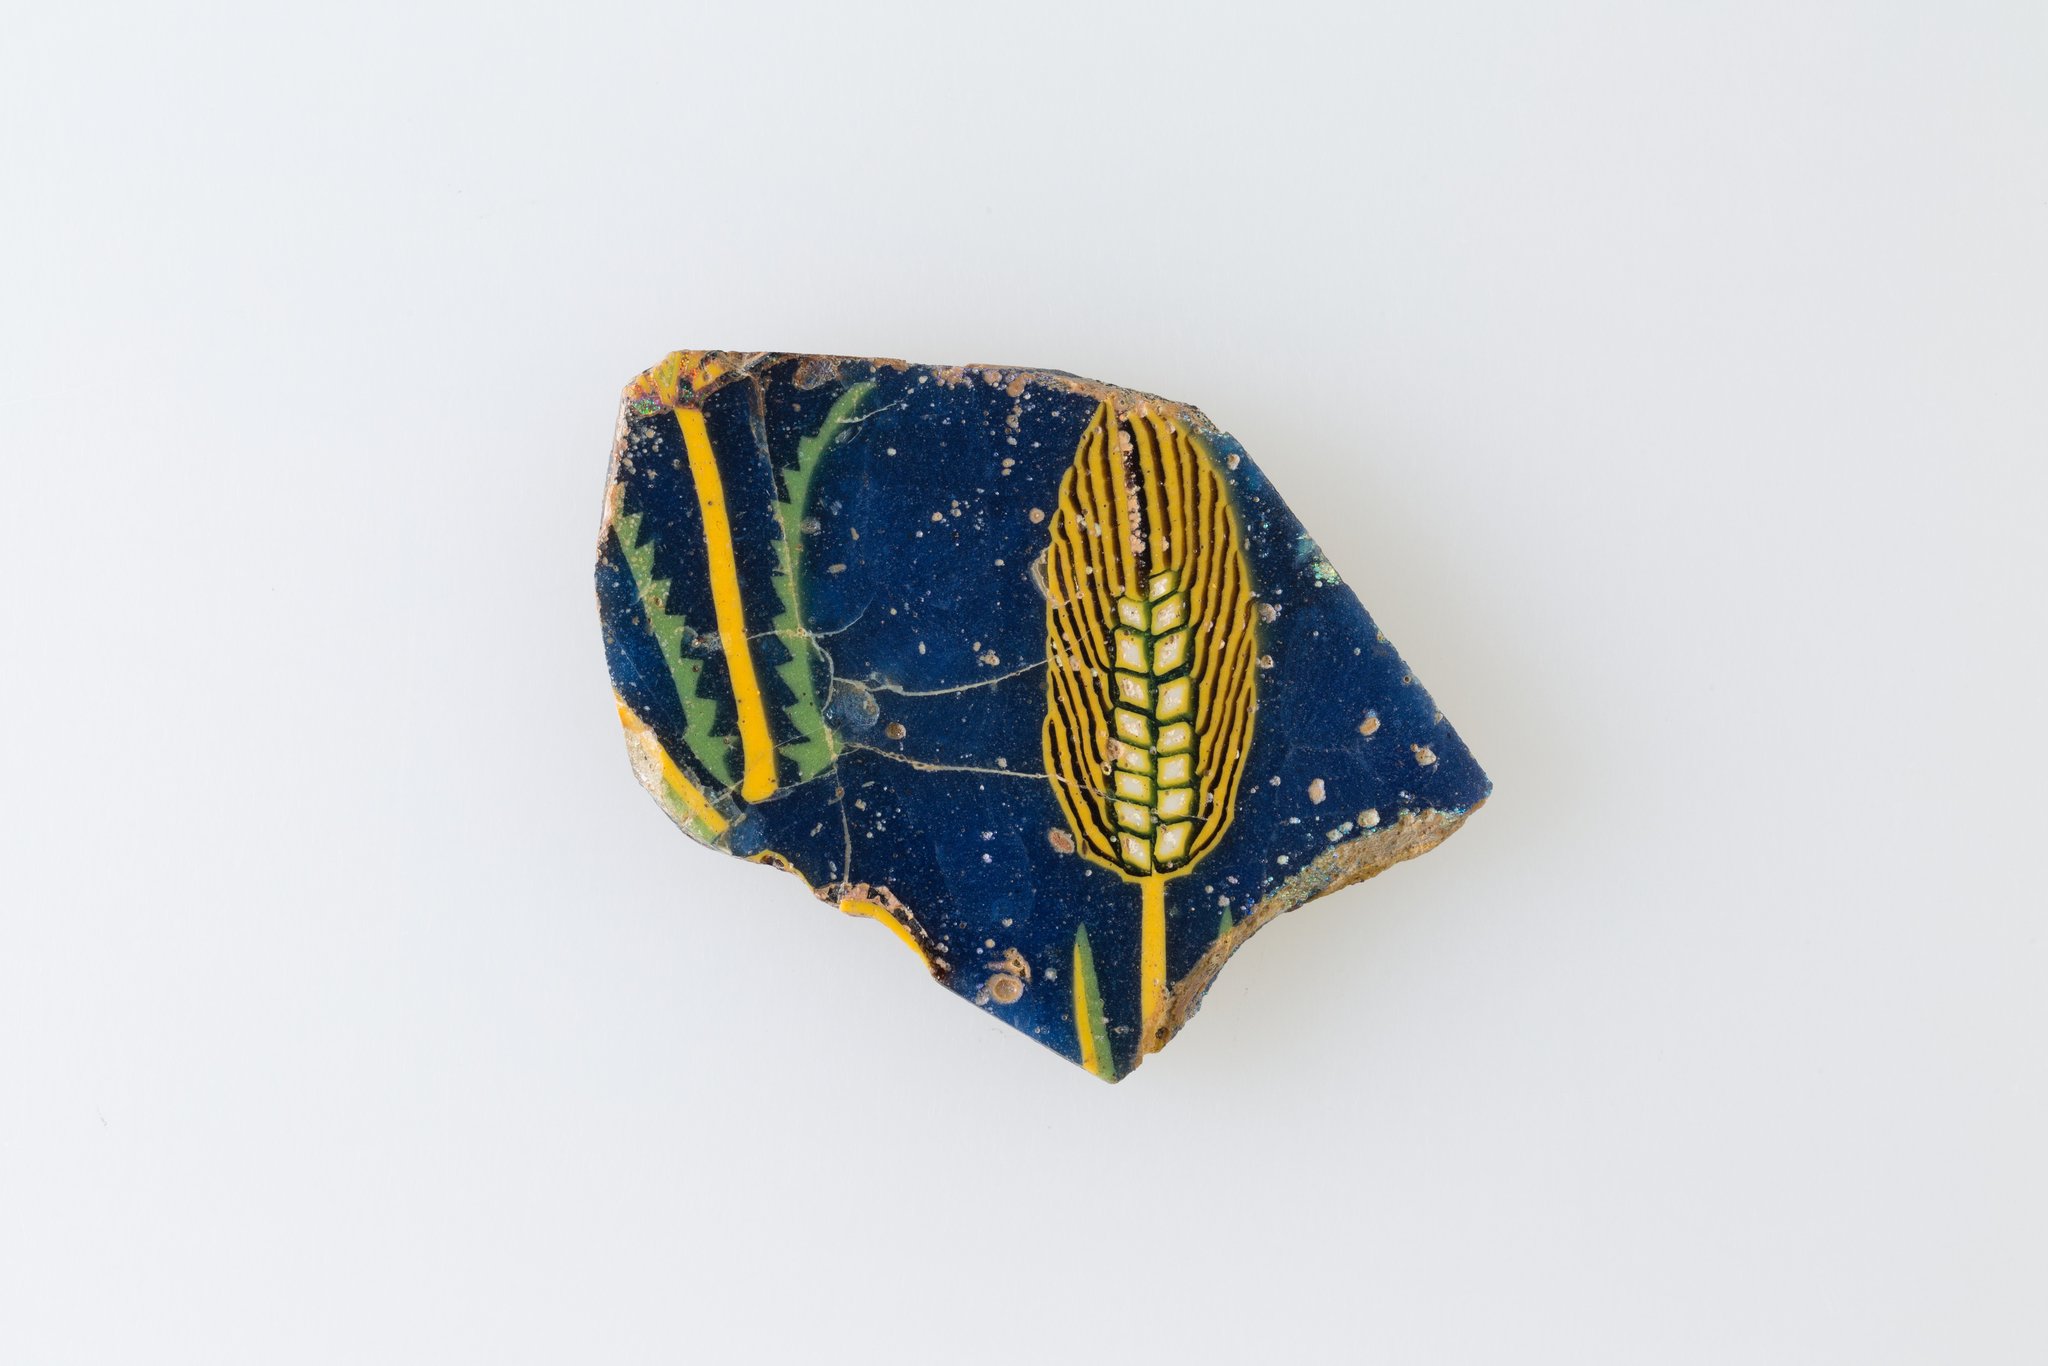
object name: plaque, floral, inlay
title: Floral plaque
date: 100 BCE-100 CE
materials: glass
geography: egypt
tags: flowers